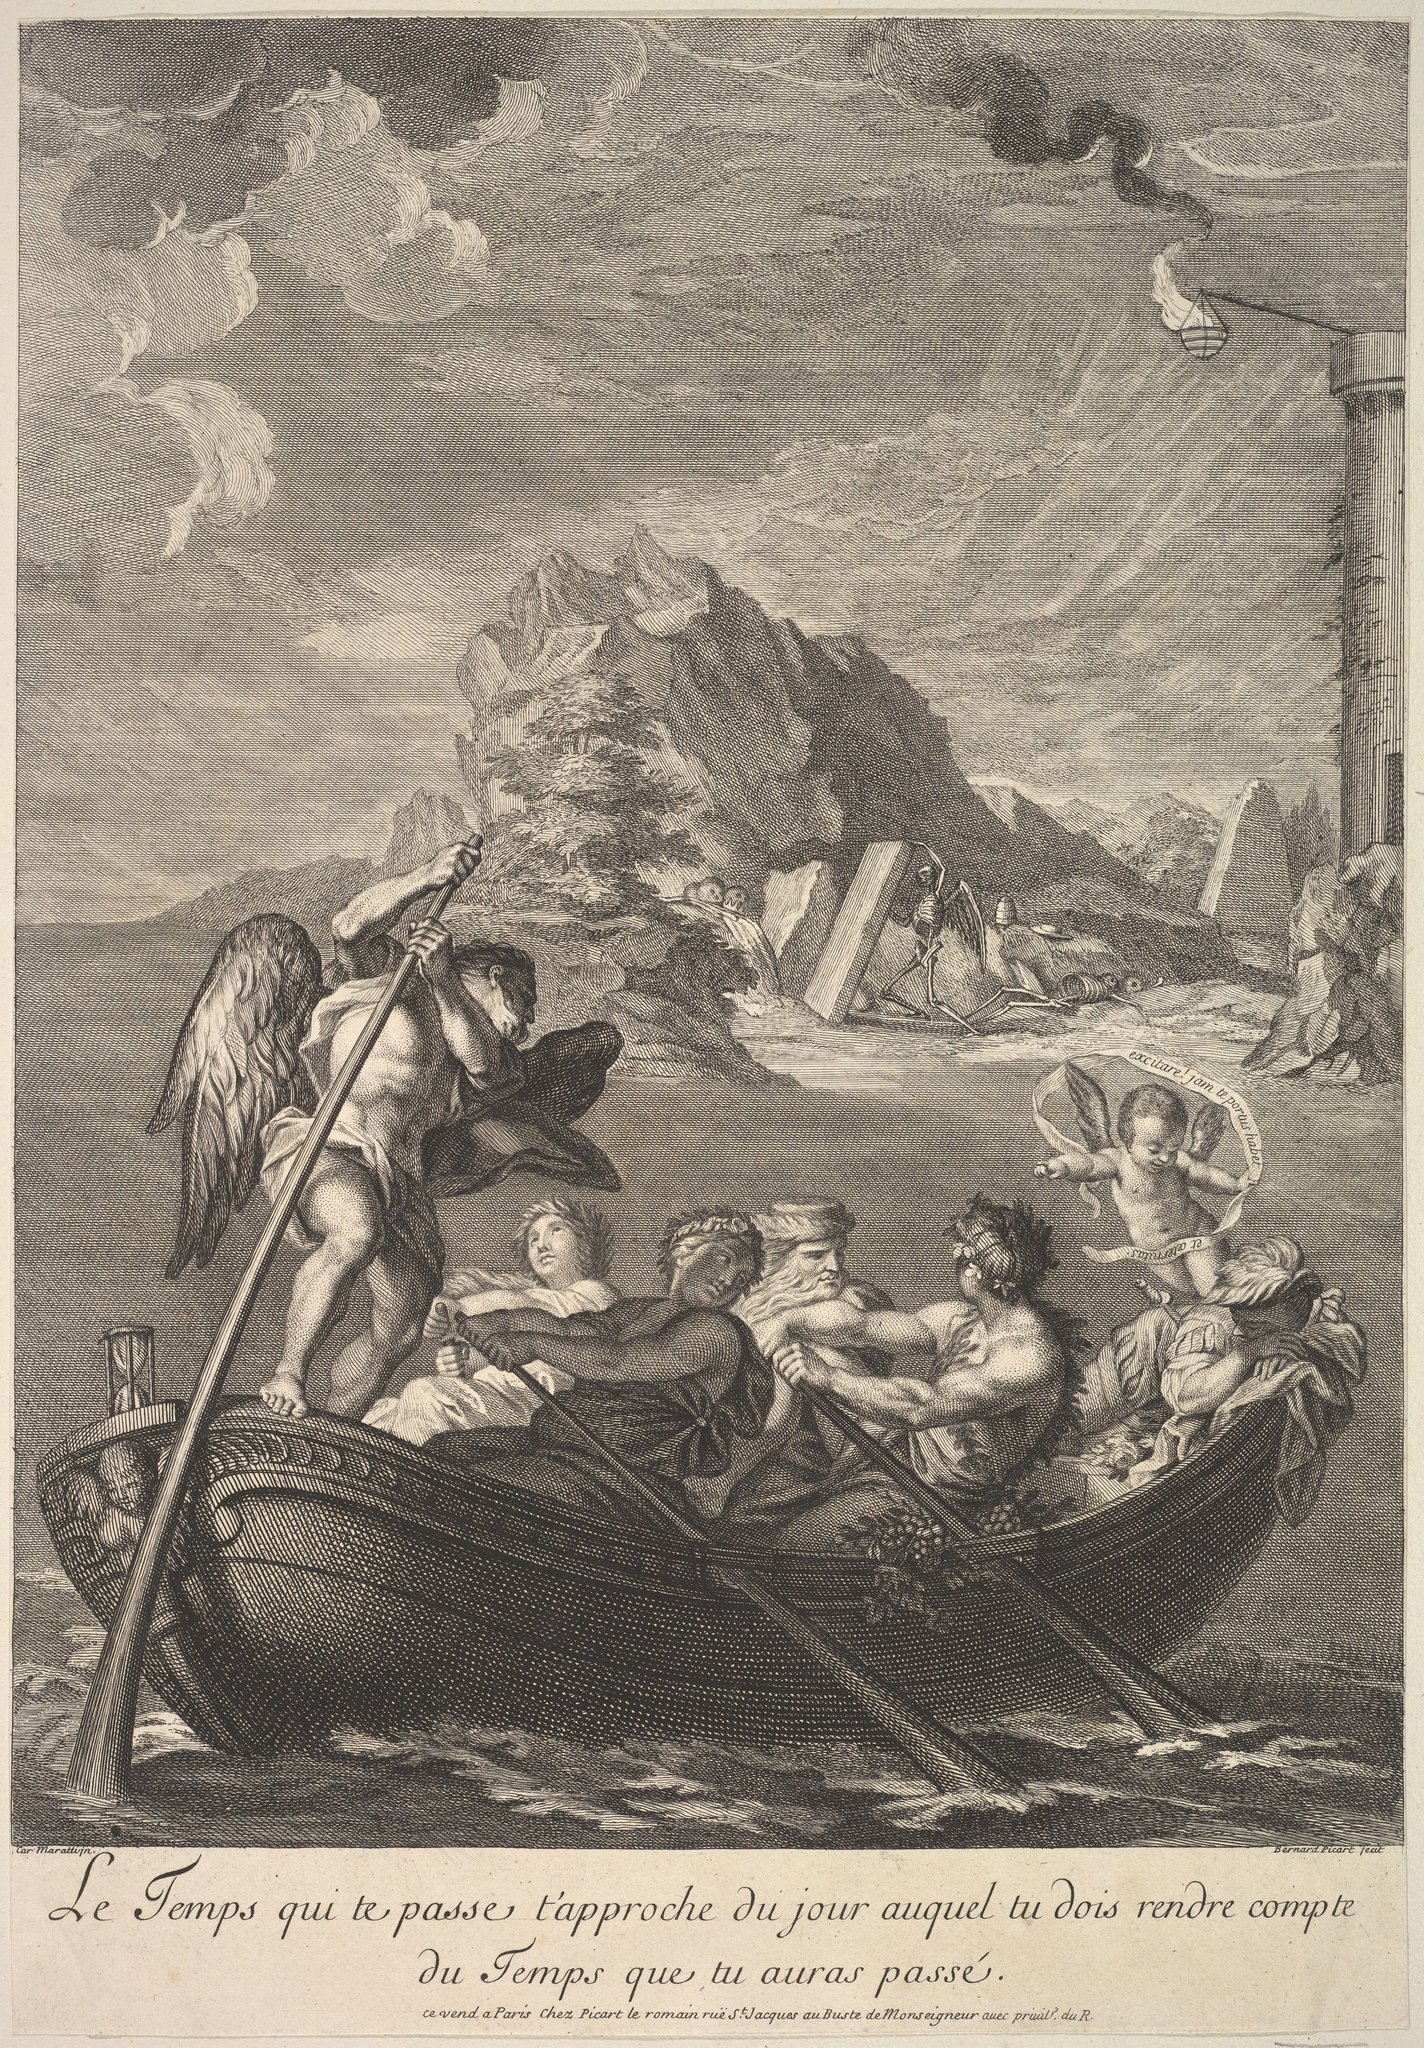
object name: print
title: Allegory of Time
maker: bernard picart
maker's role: artist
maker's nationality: french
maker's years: 1673-1733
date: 1690-1733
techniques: engraving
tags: men,women,boats